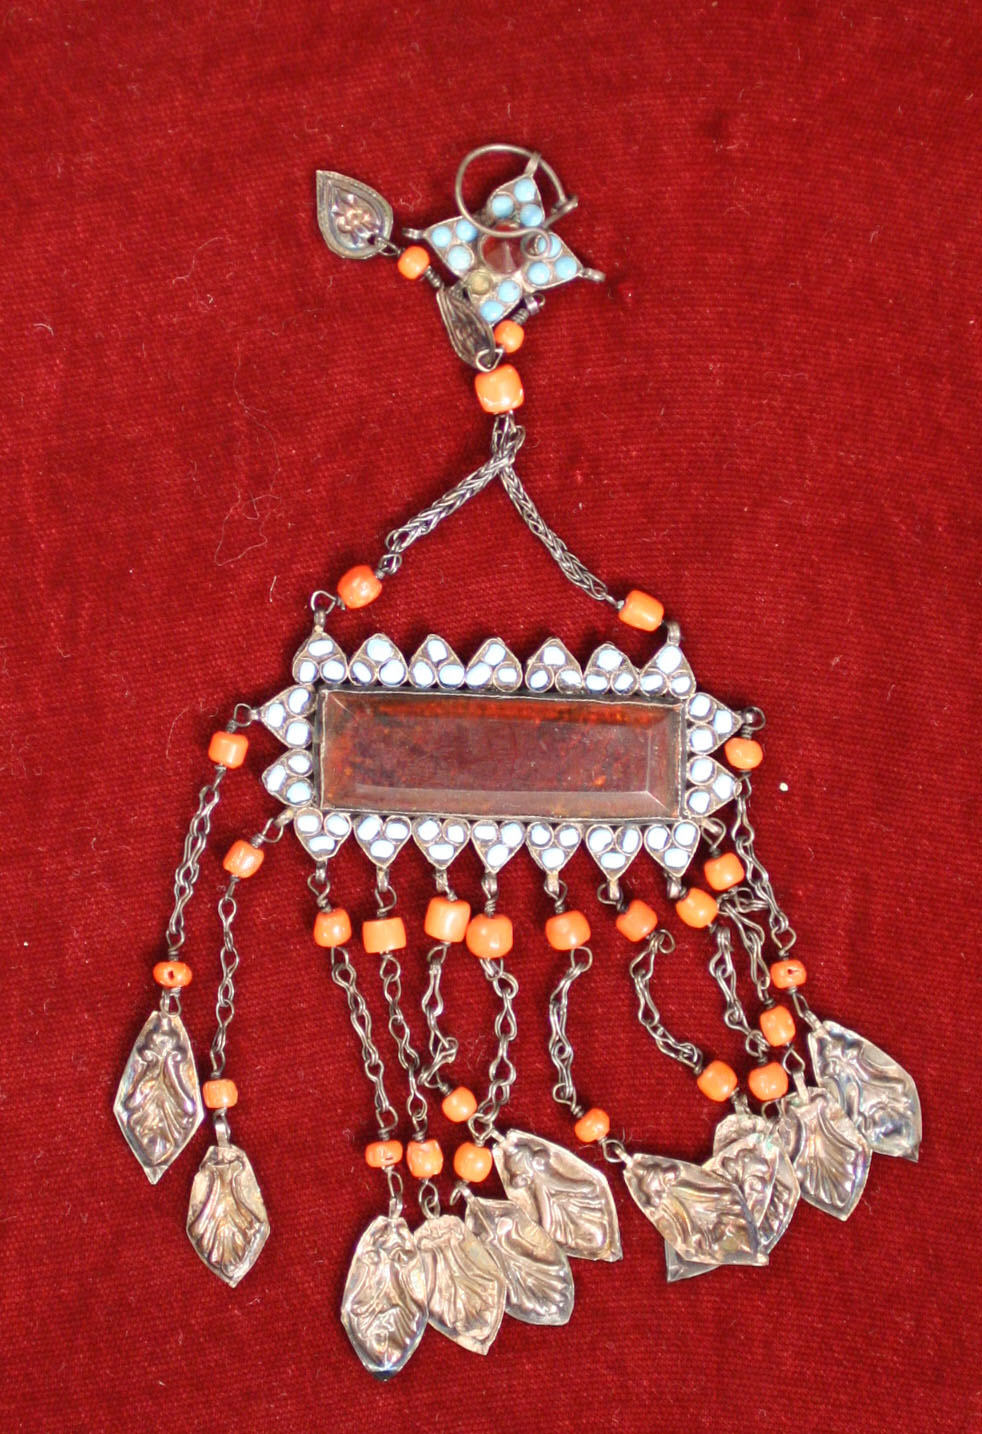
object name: pendant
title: Pendant, One of a Pair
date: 1801-1900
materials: amber, coral, silver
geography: uzbekistan